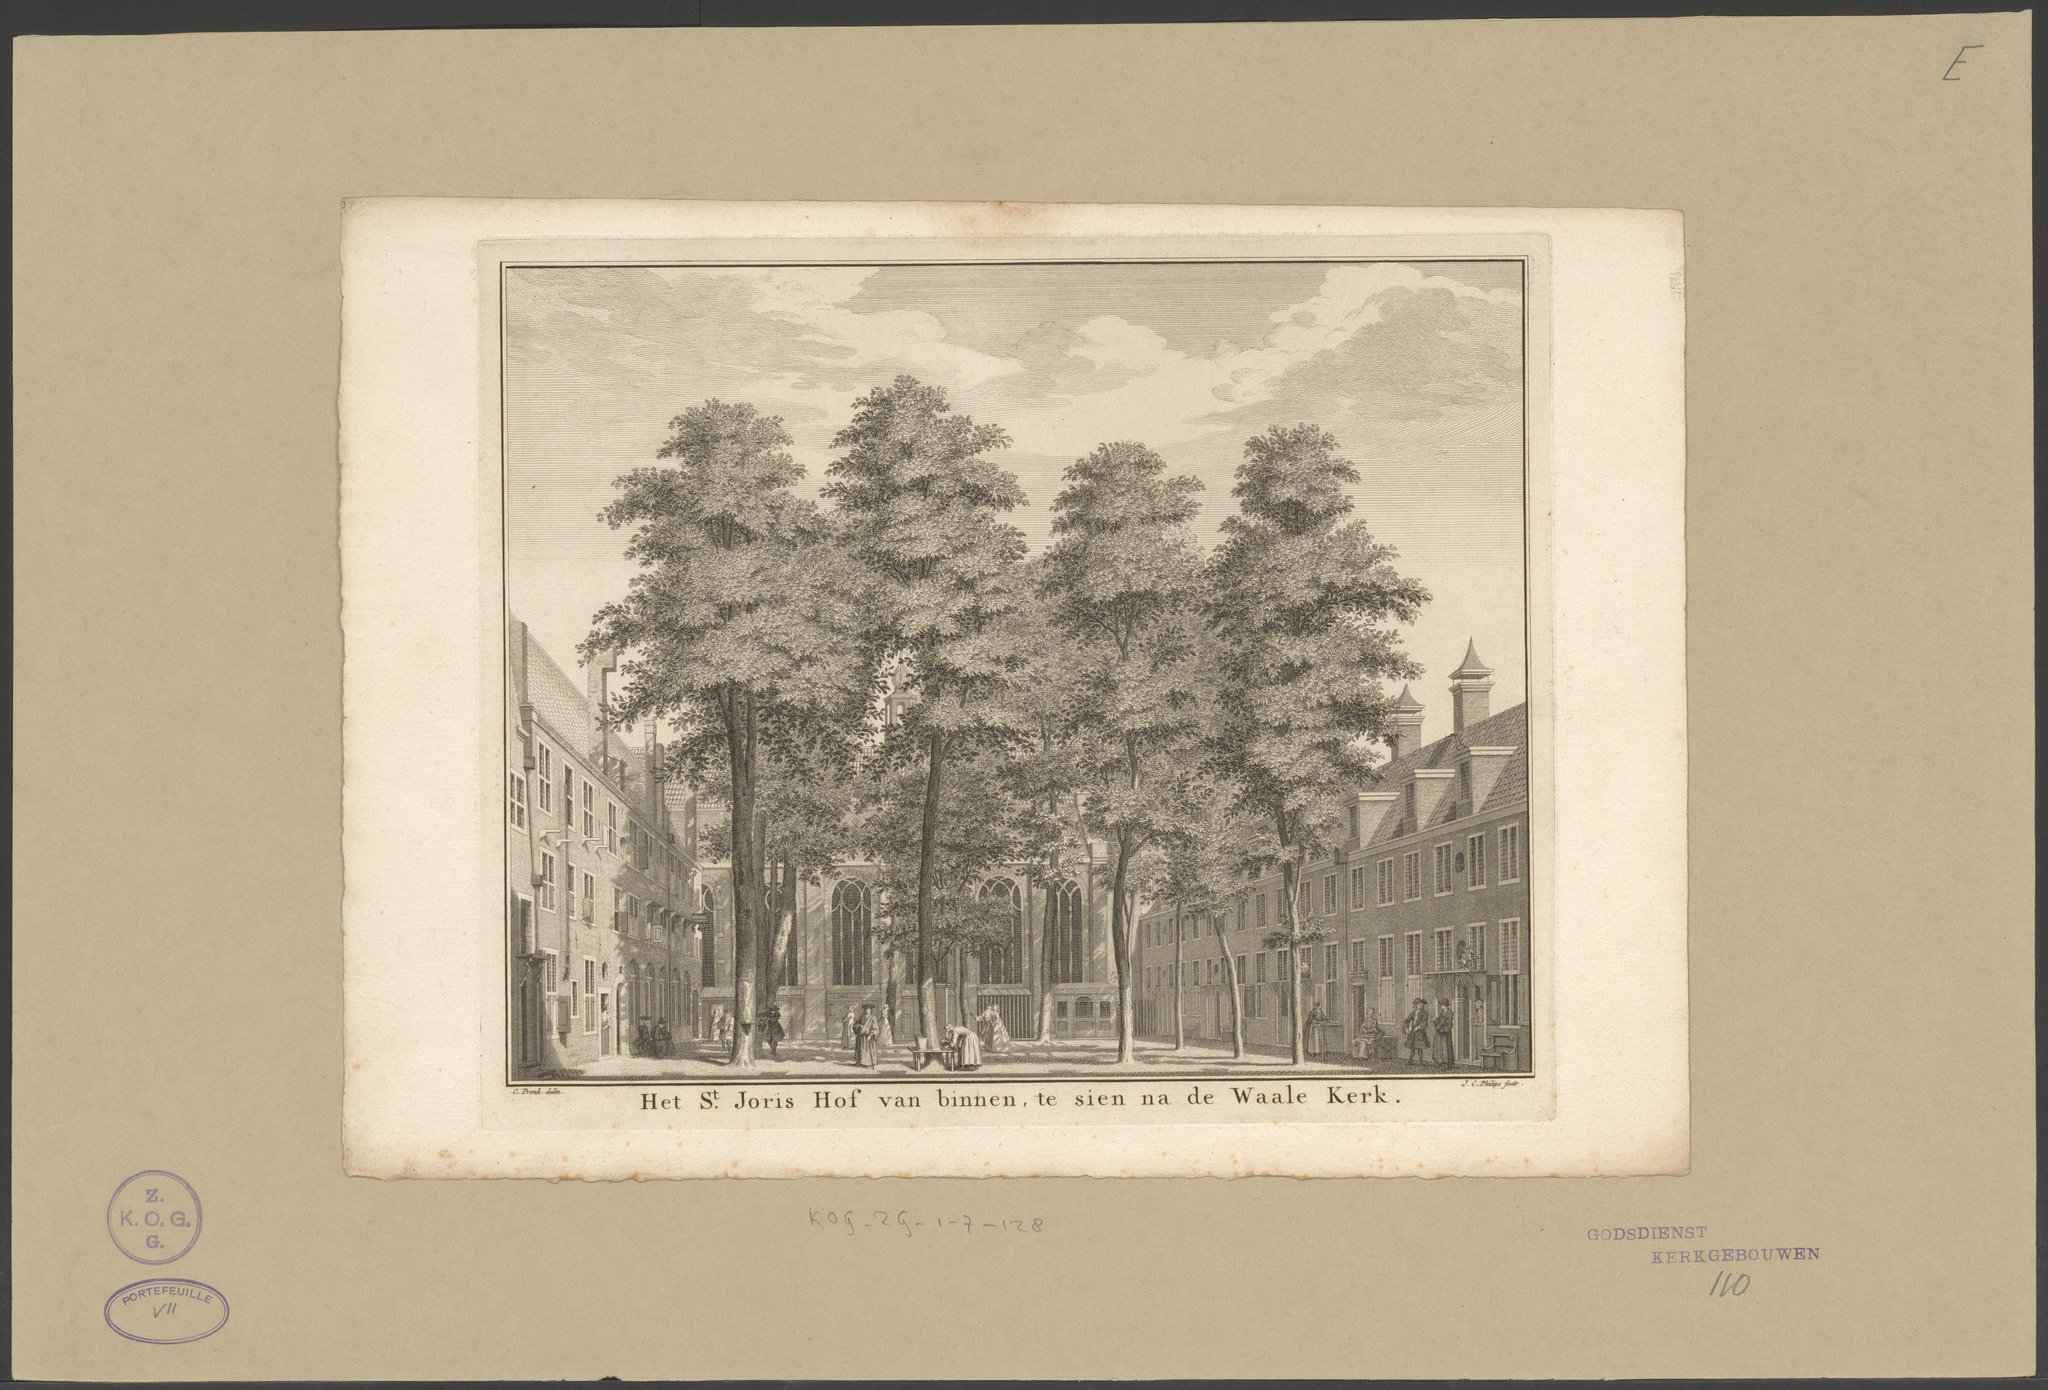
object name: print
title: Het St. Joris Hof van binnen, te sien na de Waale Kerk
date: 1730-1759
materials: paper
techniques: engraving, etching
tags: alms-house (dutch: 'hofje'), courtyard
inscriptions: stamp, stamp, collector's mark: Lugt 1641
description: Gezicht op de Waalse Kerk (op de achtergrond) en het Sint-Jorishof te Amsterdam. Op de met bomen beplante binnenplaats en voor de proveniershuizen verschillende figuren. Onderwerpsrubrieken binnen de Atlas Zeden en Gewoonten: Godsdienst, Kerkgebouwen te Amsterdam.